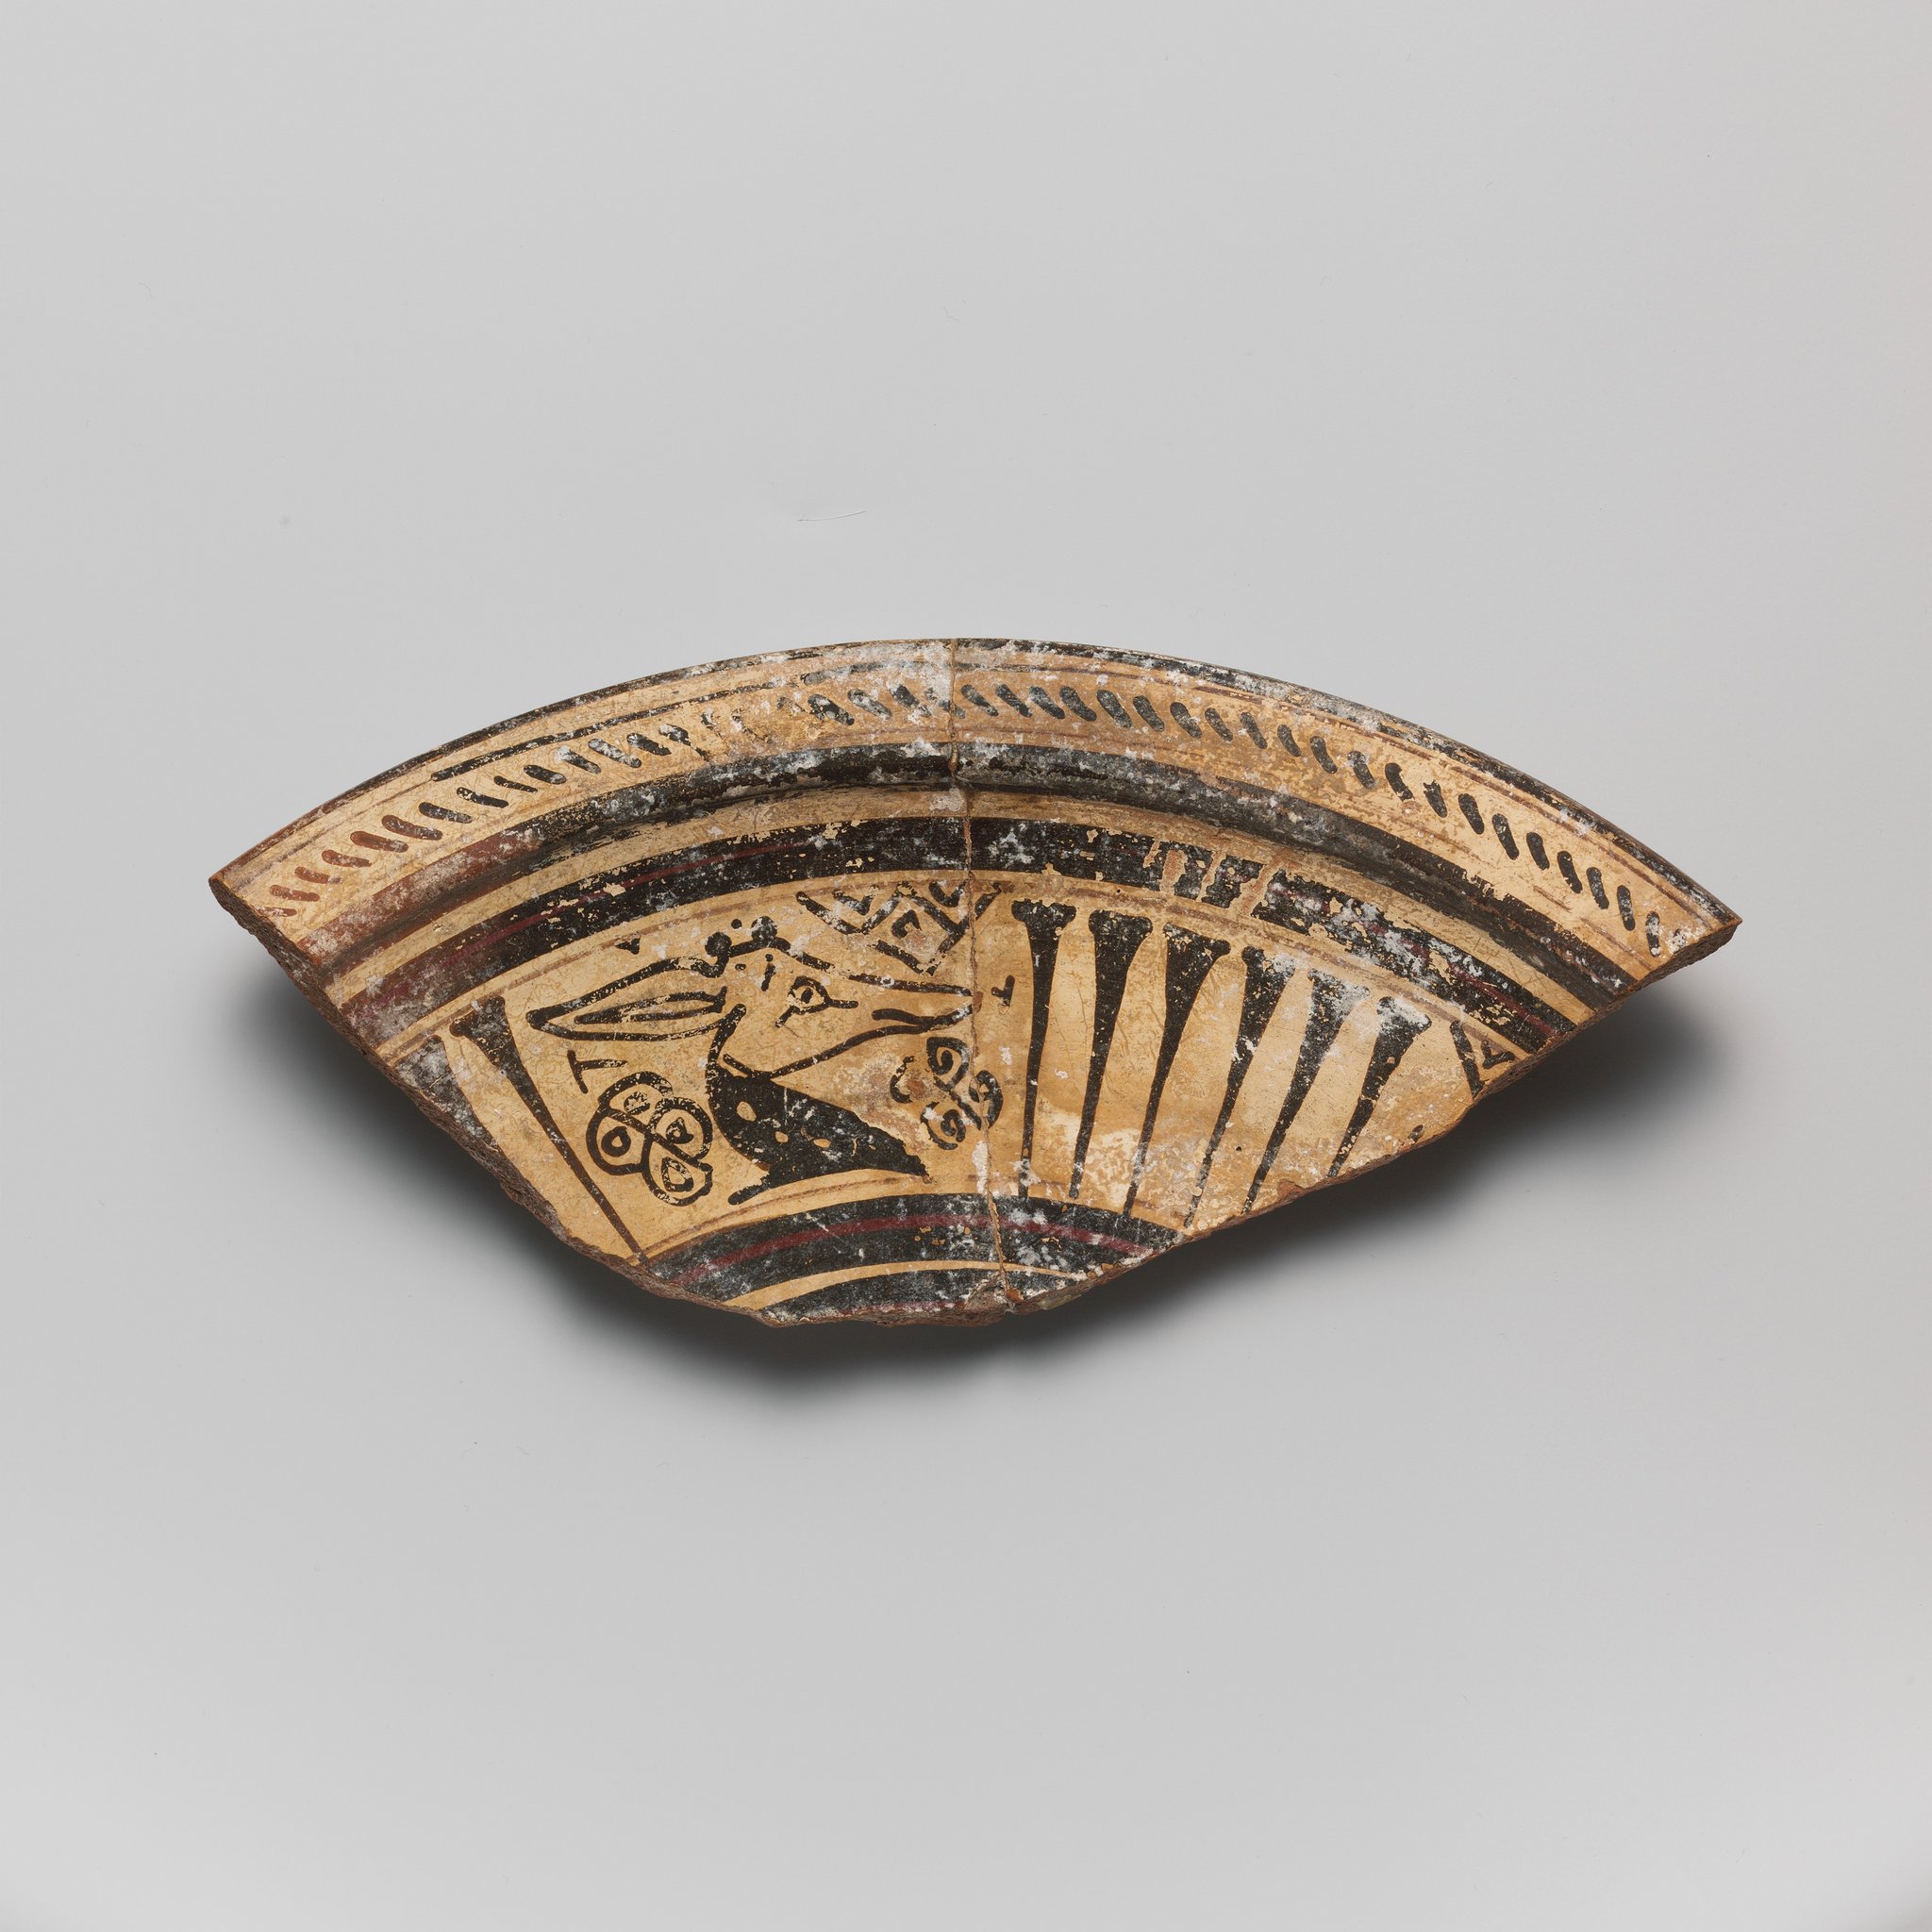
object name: fragment of a dish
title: Fragment of a terracotta stemmed dish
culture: greek, east, wild goat style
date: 634-568 BCE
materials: terracotta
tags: deer